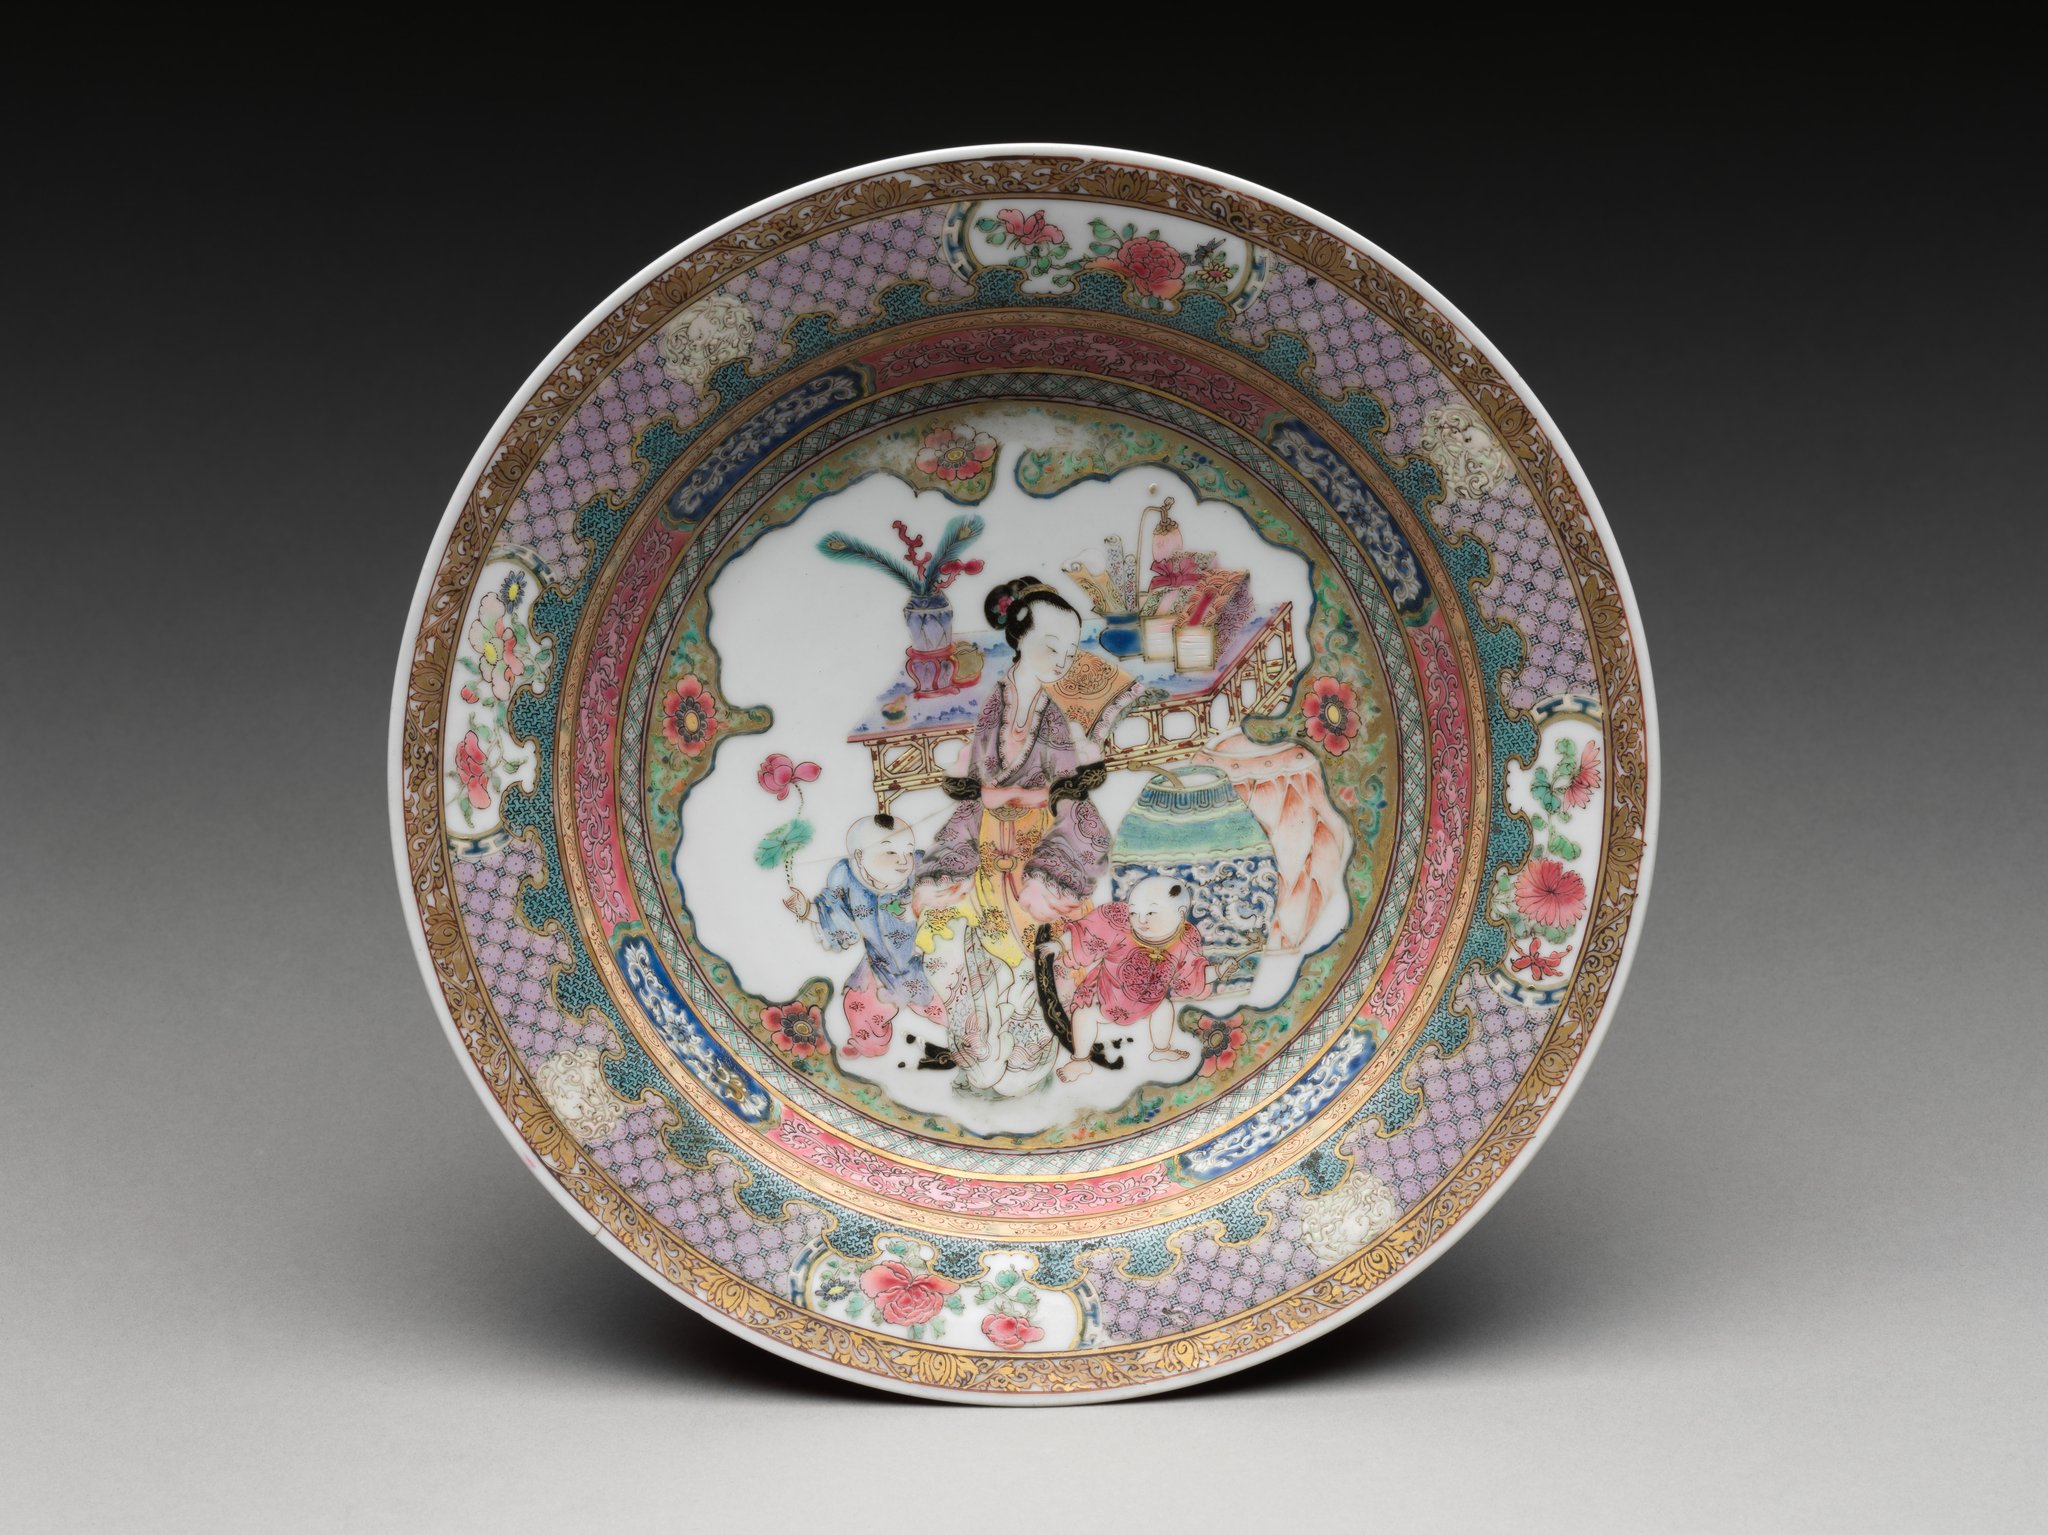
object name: dish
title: Dish with scene of a woman and children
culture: chinese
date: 1734-1766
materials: enamel, gold, porcelain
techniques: overglaze, painting, polychrome